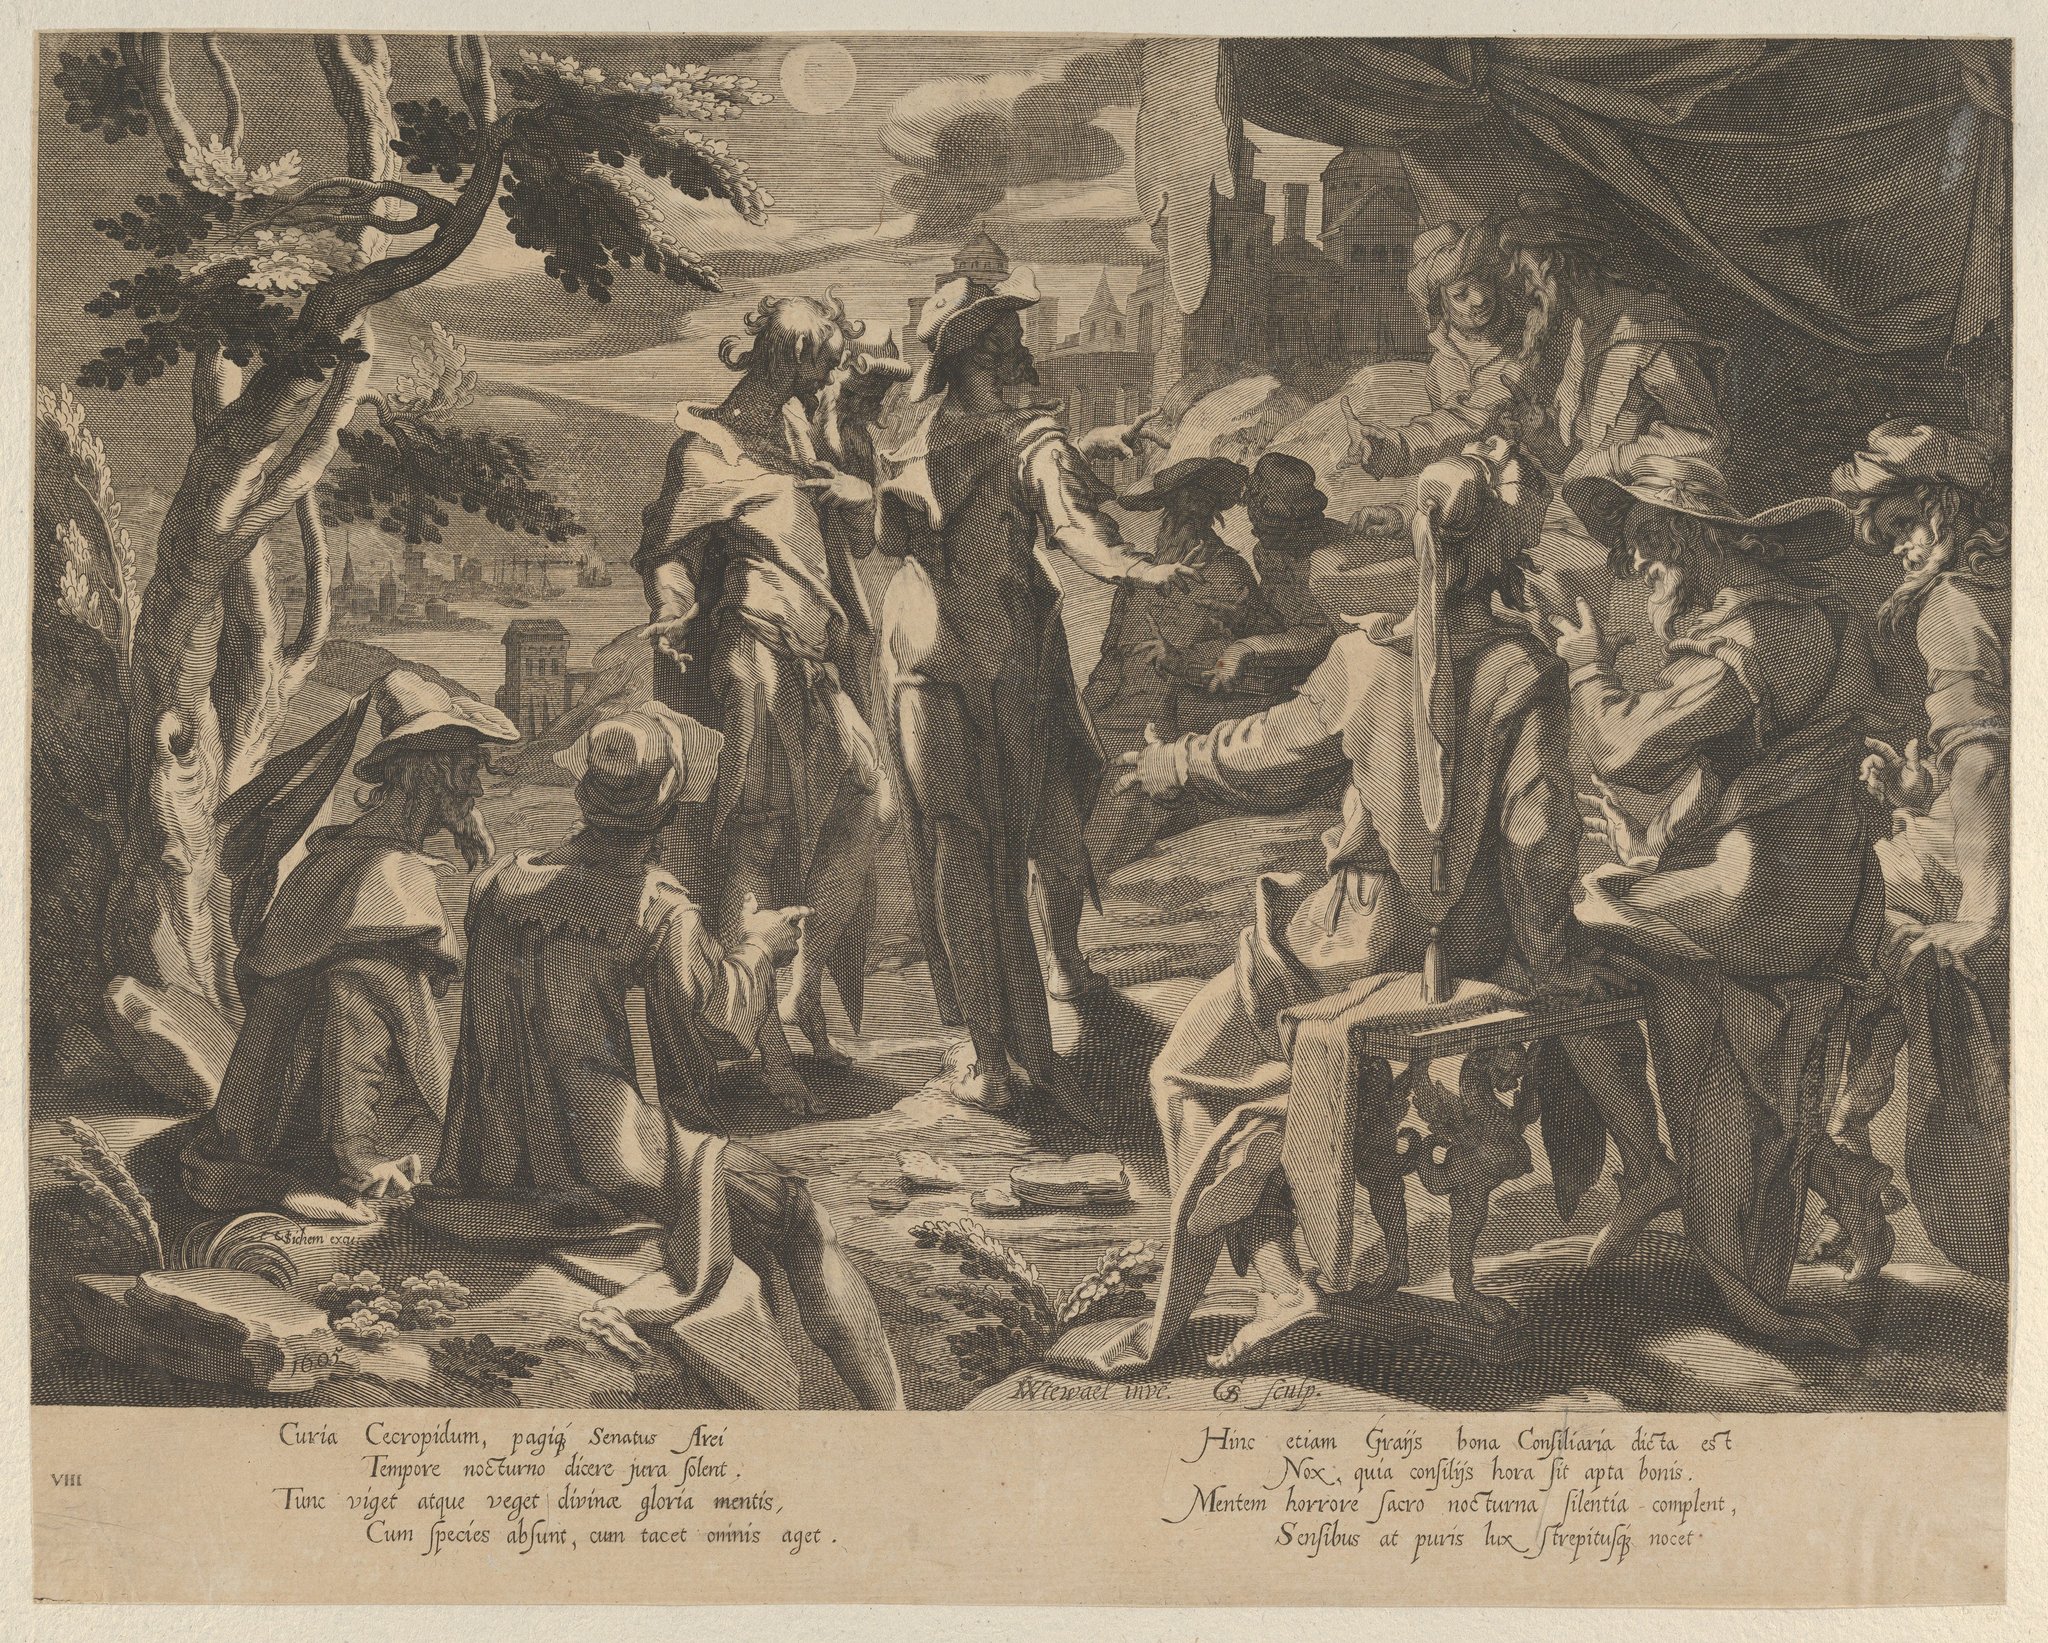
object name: print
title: A Moonlit scene depicting the Areopagite judged of Athens, plate 8 from "Thronus Justitiae, tredecim pulcherrimus tabulis..."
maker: willem van swanenburg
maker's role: artist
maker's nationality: netherlandish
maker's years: 1581-1612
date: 1605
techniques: engraving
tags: men,moon,night